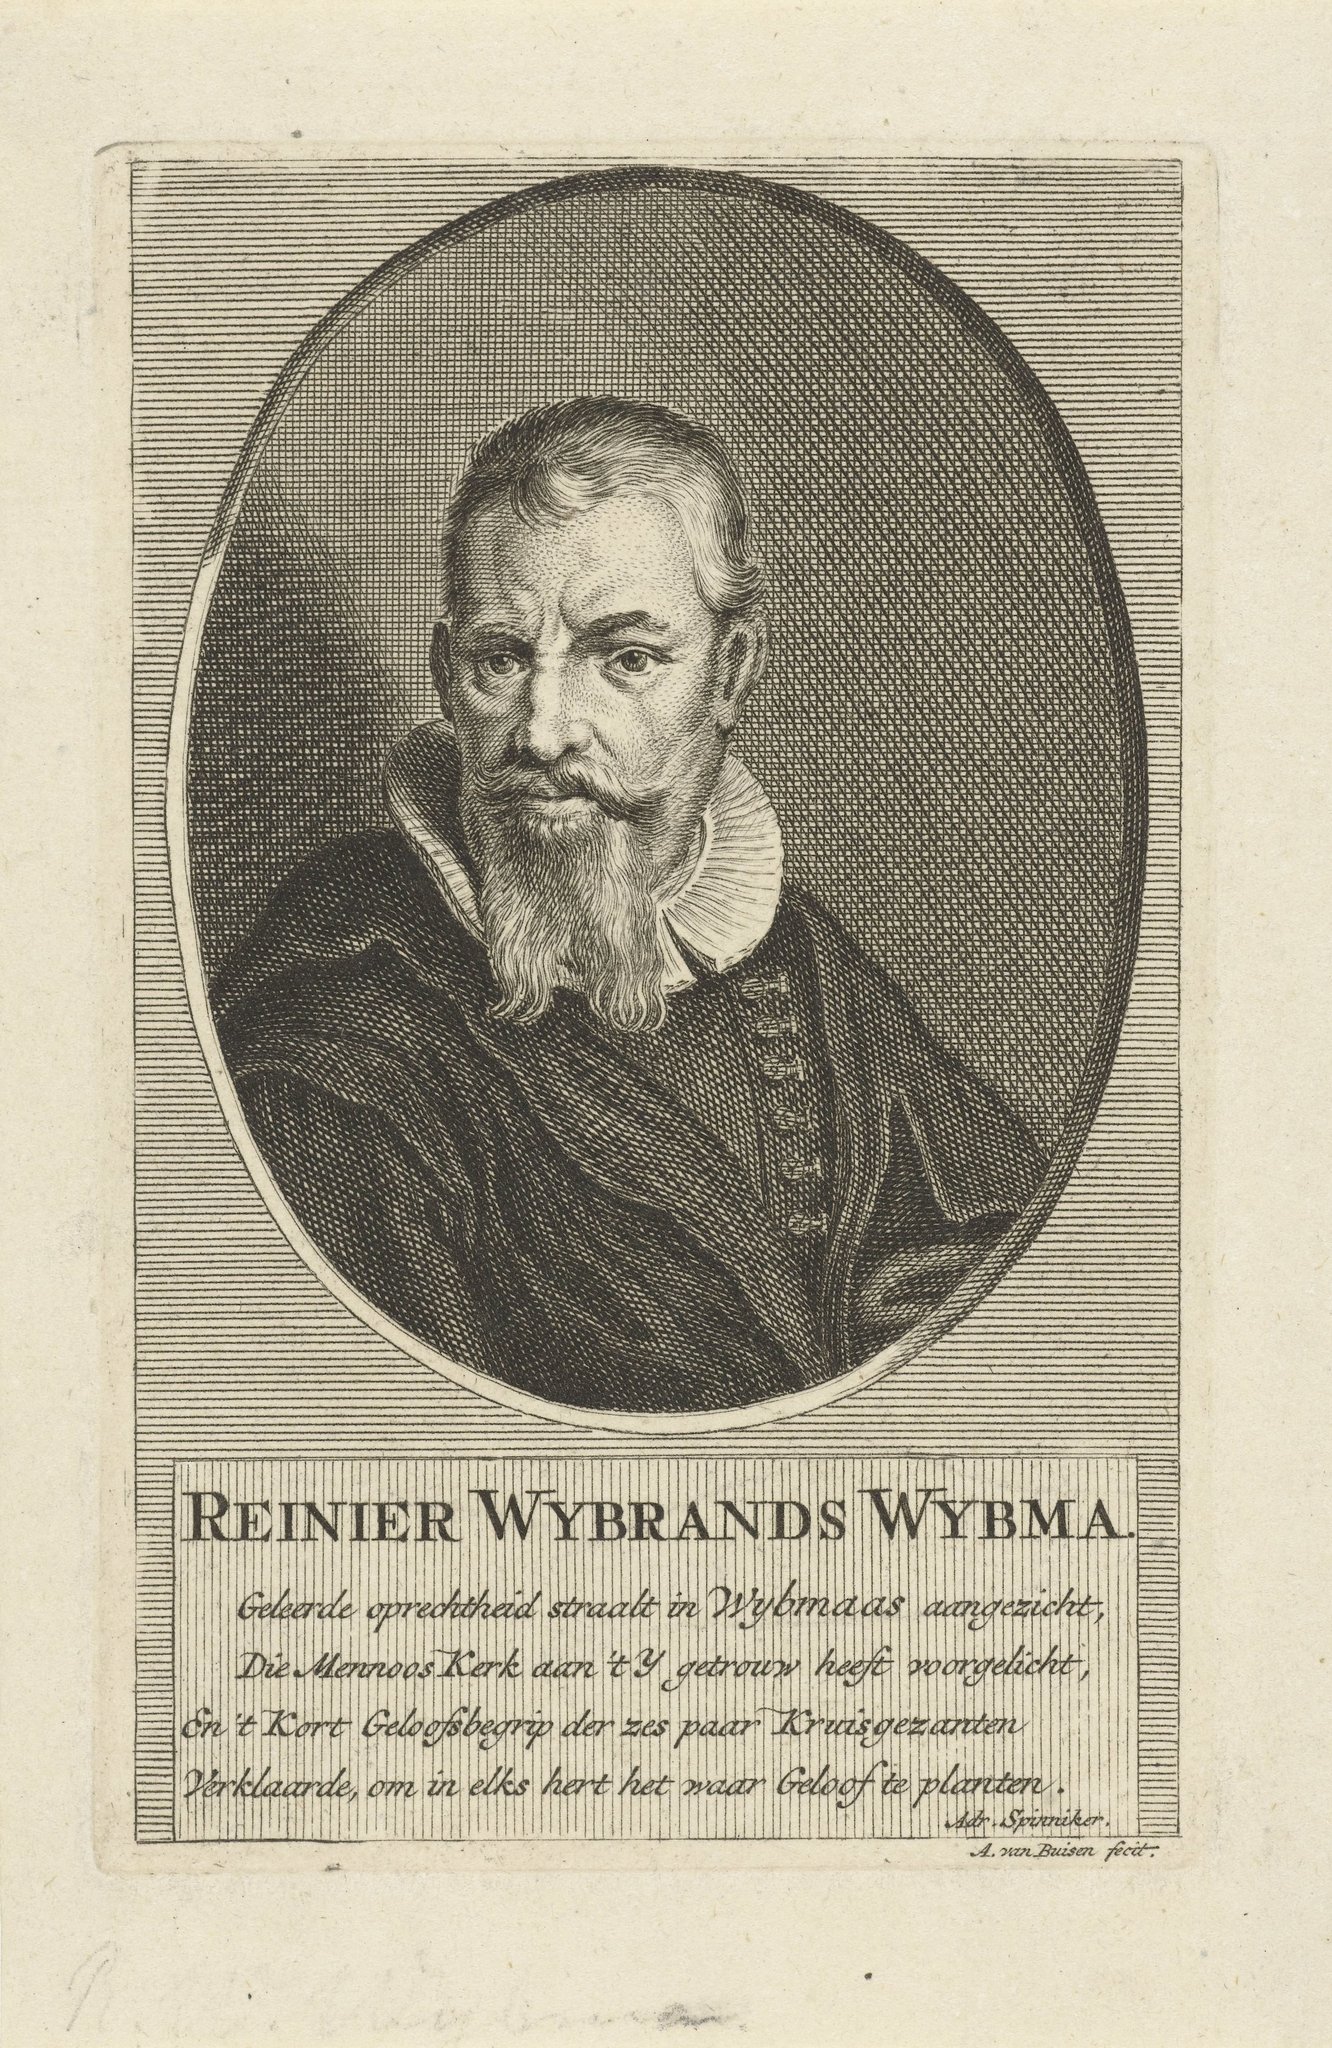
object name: print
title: Portret van Reinier Wybrands Wybma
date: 1743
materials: paper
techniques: engraving, etching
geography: amsterdam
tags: predikant, auteur, reinier wybrands wybma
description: Portretbuste van Reinier Wybrands Wybma, in ovaal. Onder het portret een vers van Adriaan Spinniker.